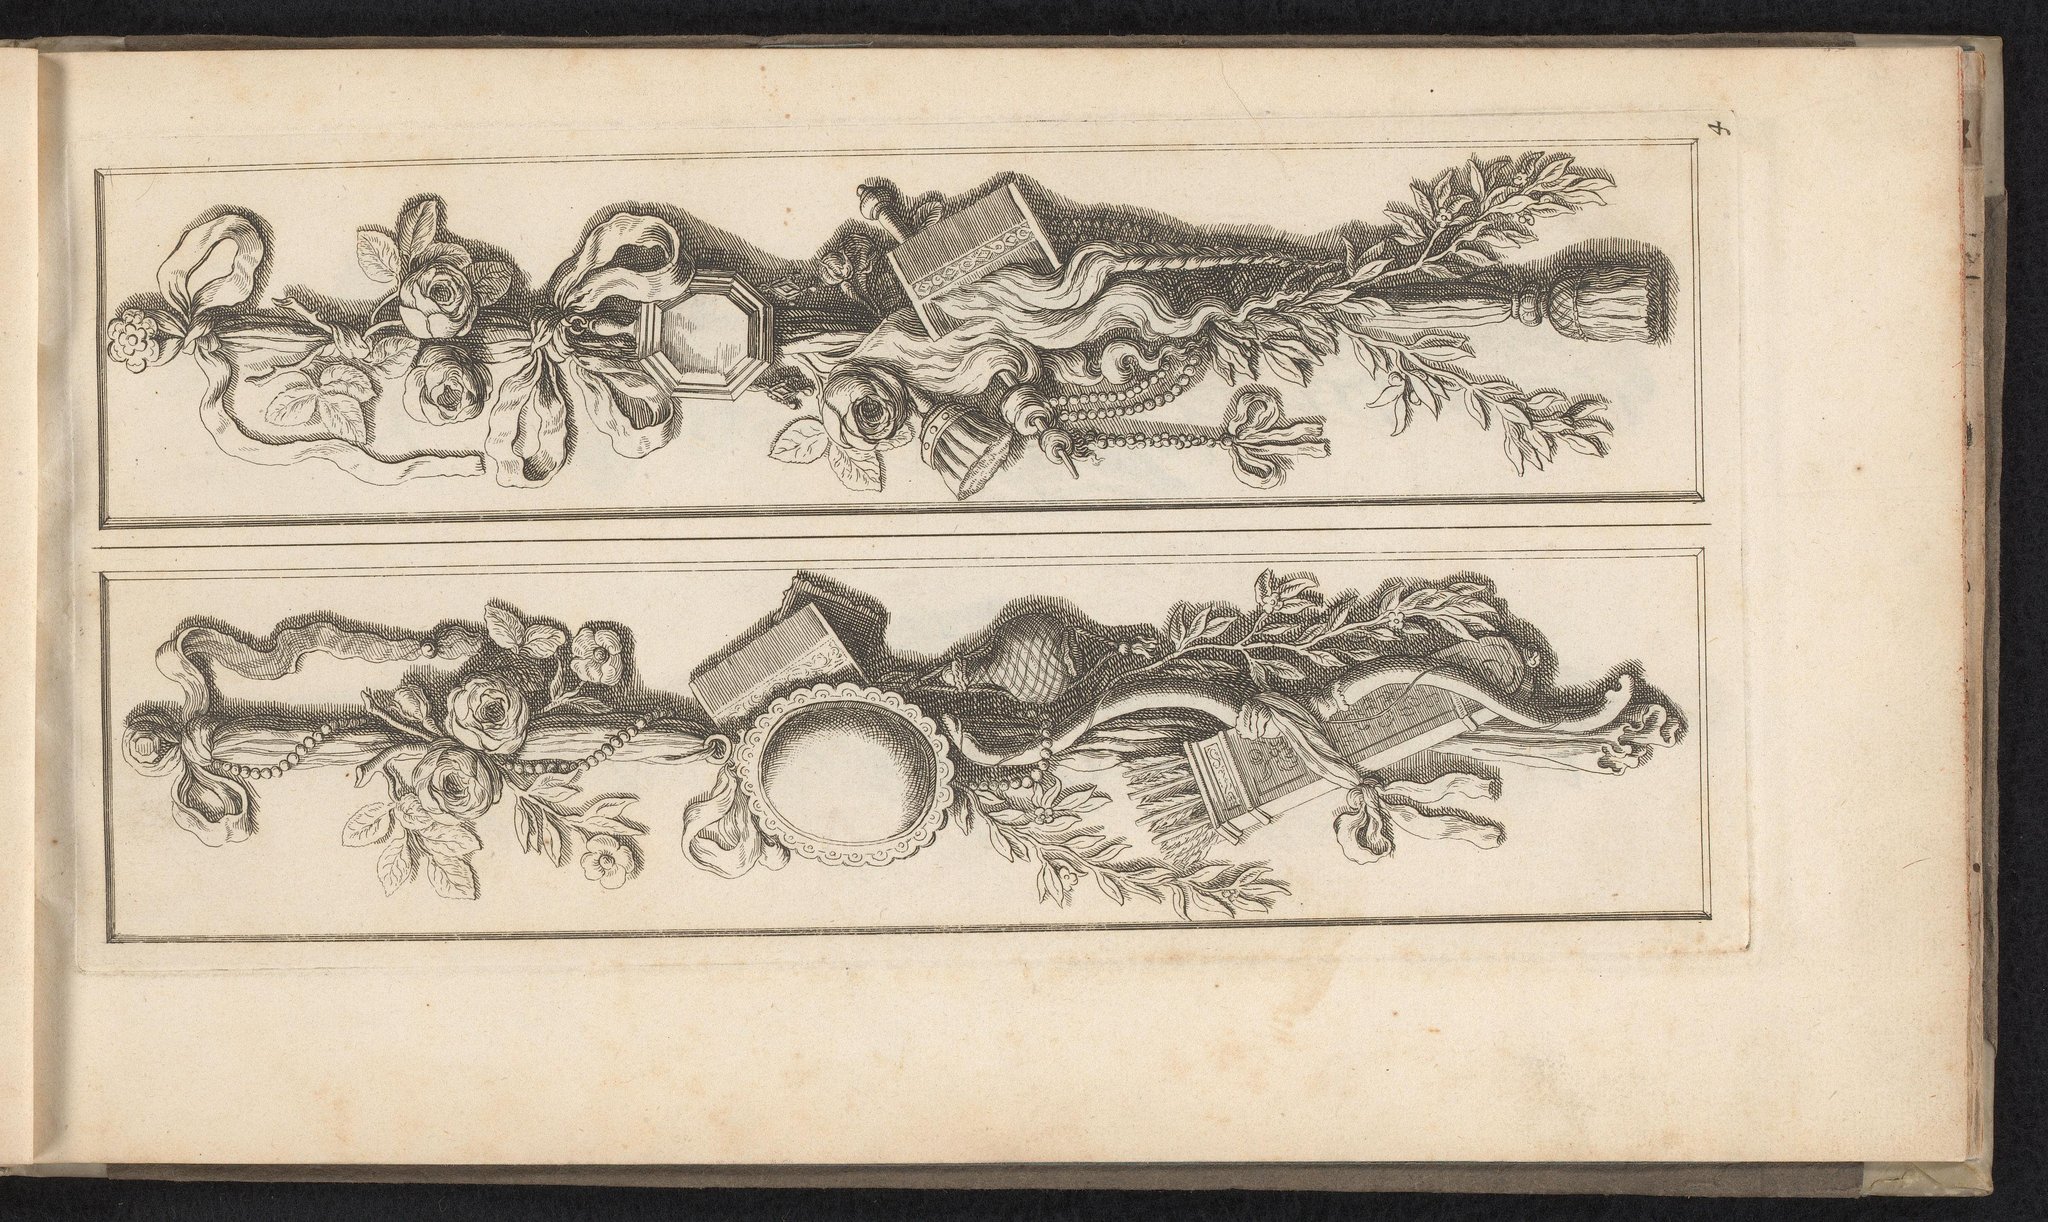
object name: ornament print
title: Pilasterfestoenen met toiletaccessoires uit het stadhuis van Amsterdam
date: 1665-1685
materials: ink, paper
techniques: etching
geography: amsterdam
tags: making toilet, comb, brush and other tools (care of the hair), ornament ~ festoon, garland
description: Een van vijf genummerde prenten met festoenen met titelpagina. Kopieën in spiegelbeeld naar de prenten in Artus Quellinus, Prima Pars Praecipuarium (…), Amsterdam 1665. Gebonden in 19de-eeuwse band met blauwe kaft en witte rug, genummerd: 3.